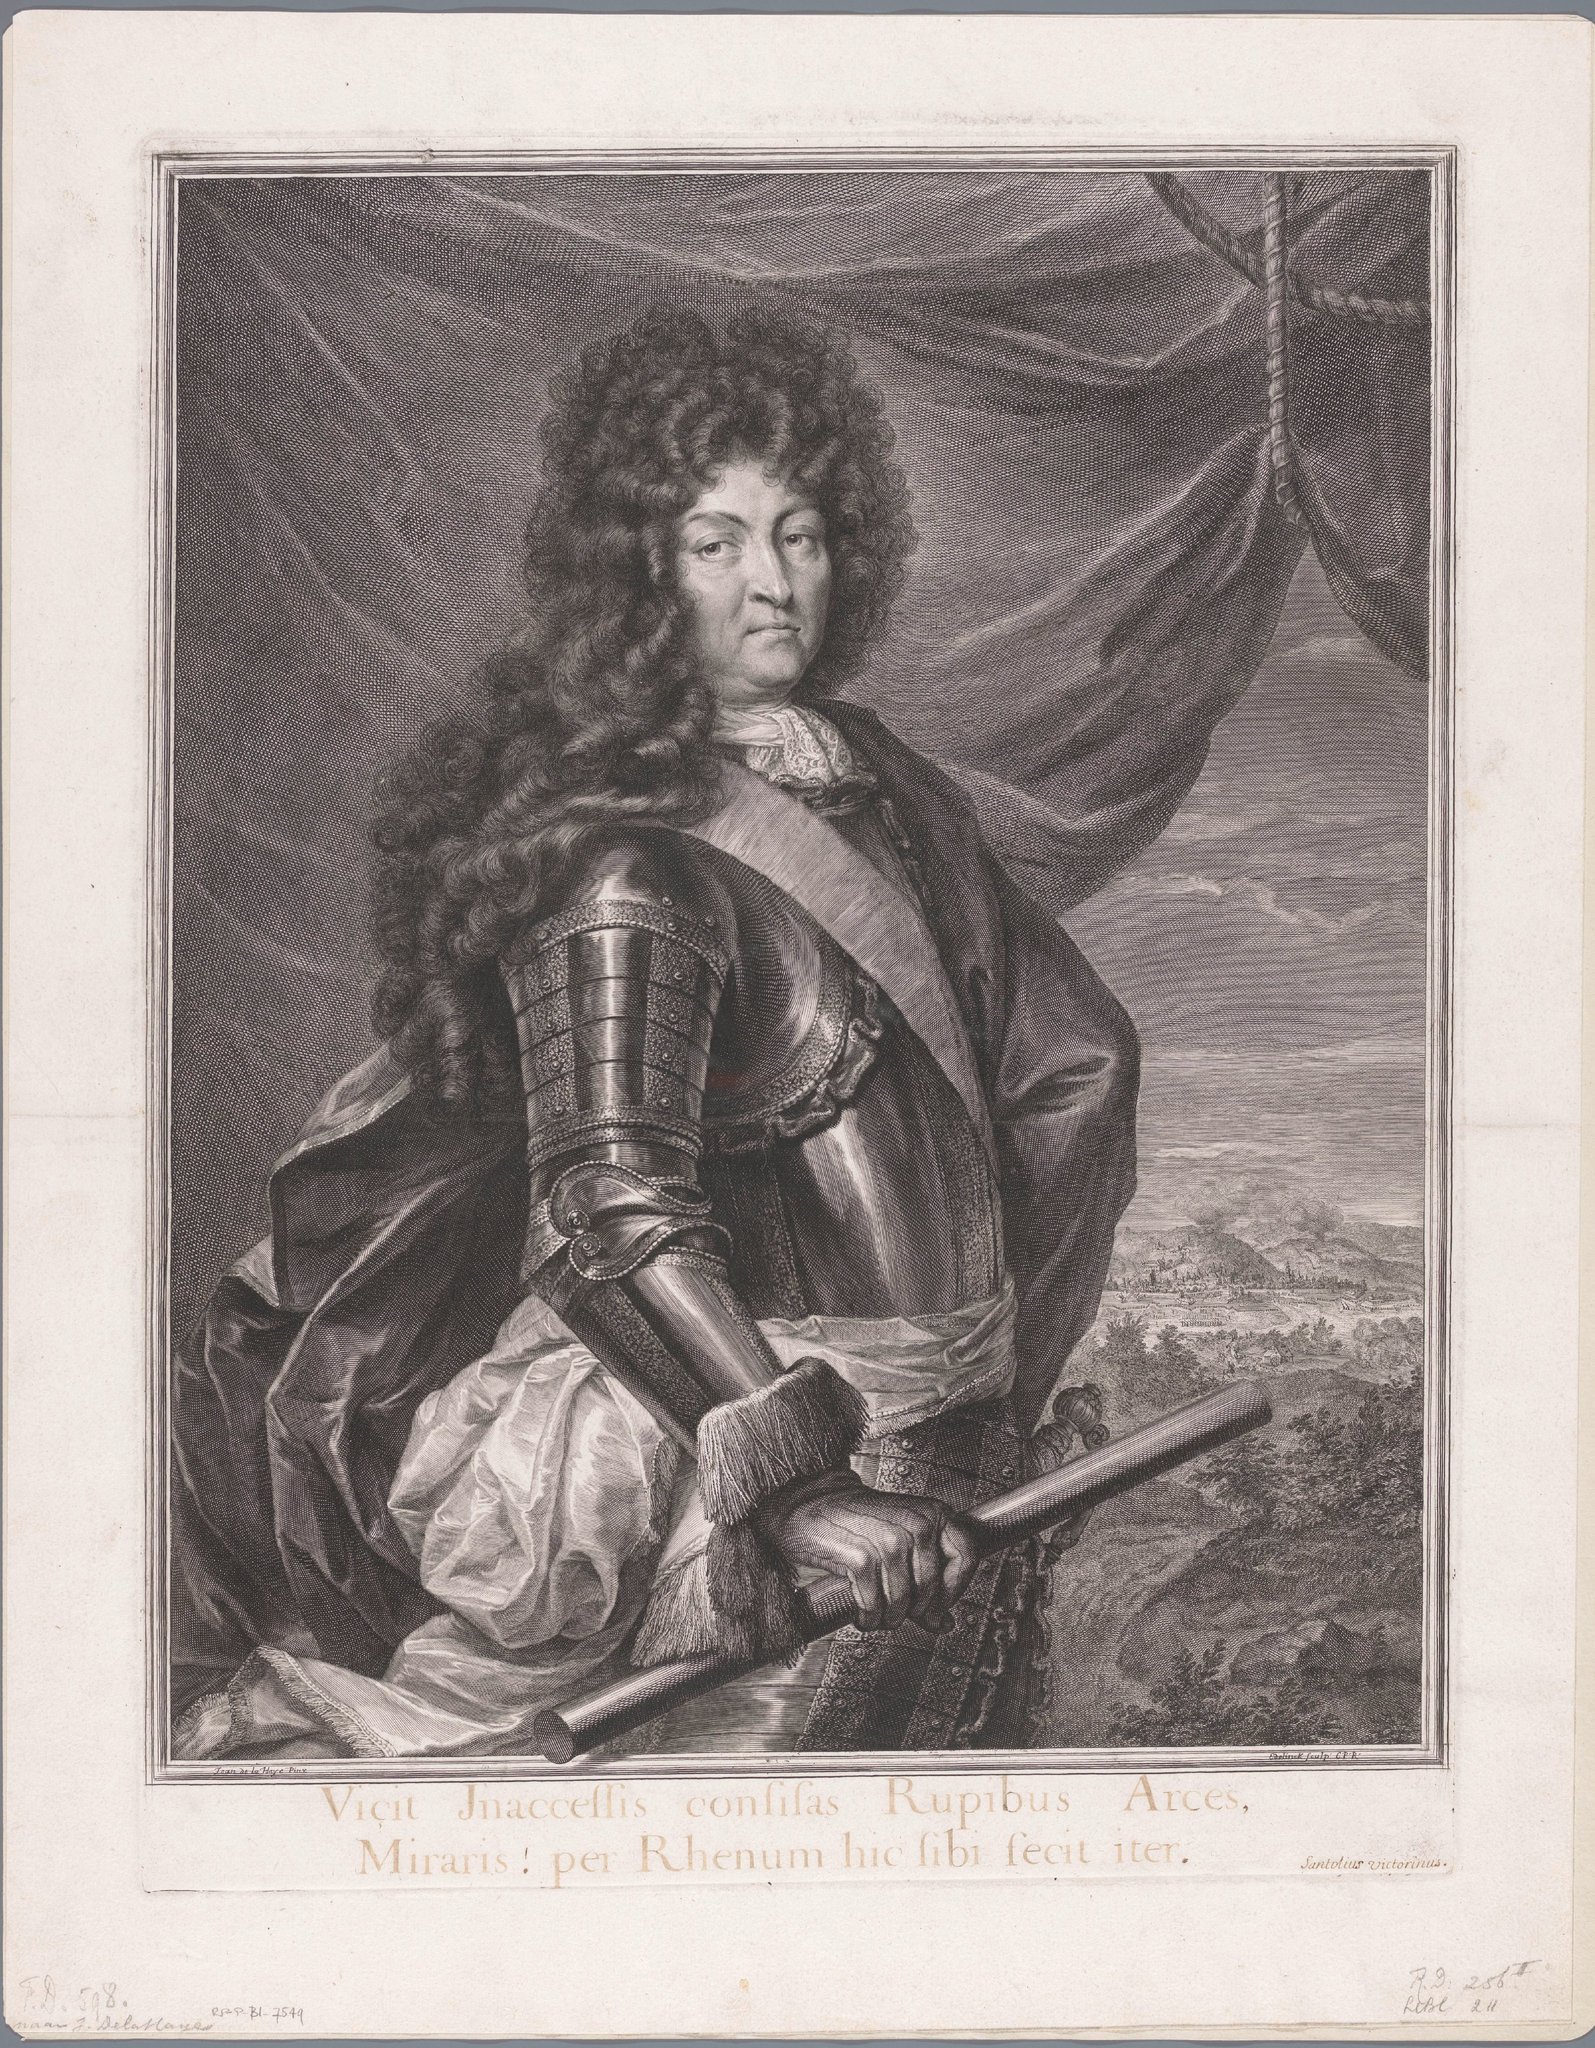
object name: print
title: Portret van Lodewijk de XIV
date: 1666-1707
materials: paper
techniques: engraving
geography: paris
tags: lodewijk xiv (koning van frankrijk)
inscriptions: collector's mark: Lugt 240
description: Portret ten halven lijve van Lodewijk de XIV. De koning is gekleed in harnas met mantel en heeft in zijn rechter hand een commandostaf. Langs het geopende gordijn een gezicht op een landschap met een belegerde stad. Onder de voorstelling een Latijns opschrift van twee regels.